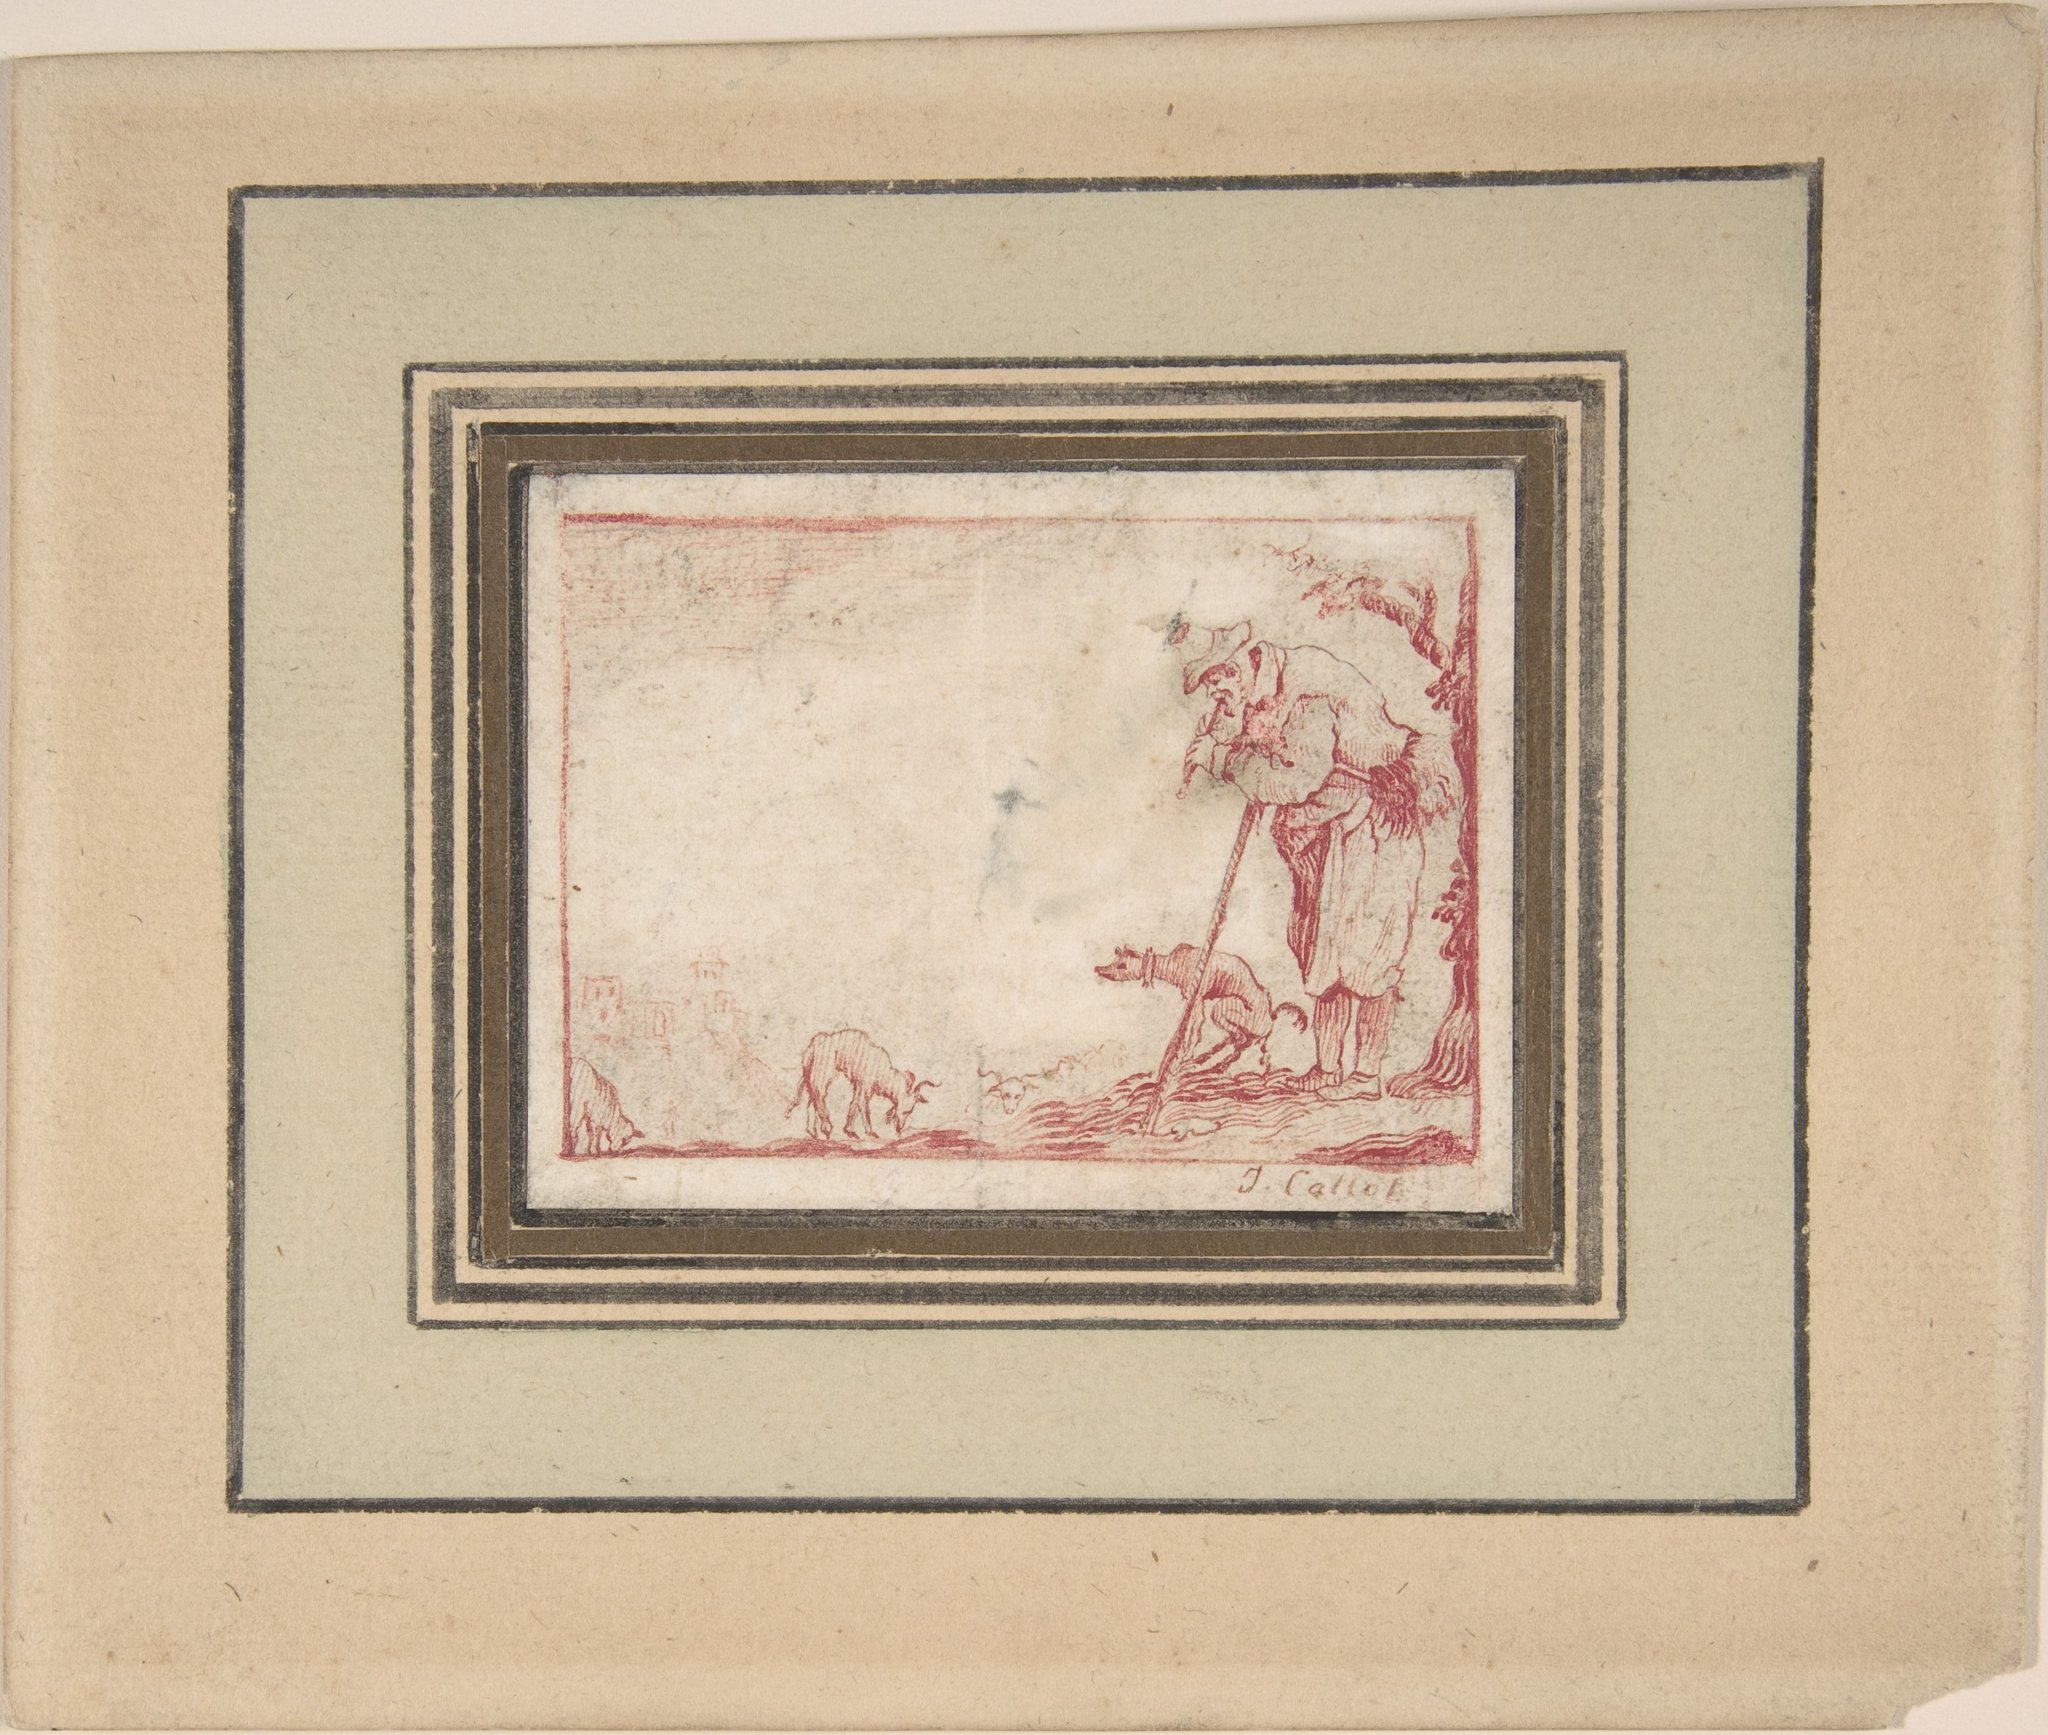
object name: drawing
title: A Beggar Playing a Flute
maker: jacques callot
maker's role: artist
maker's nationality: french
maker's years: 1592-1635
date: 1601-1633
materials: graphite, ink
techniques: pen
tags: men,music,flutes,dogs